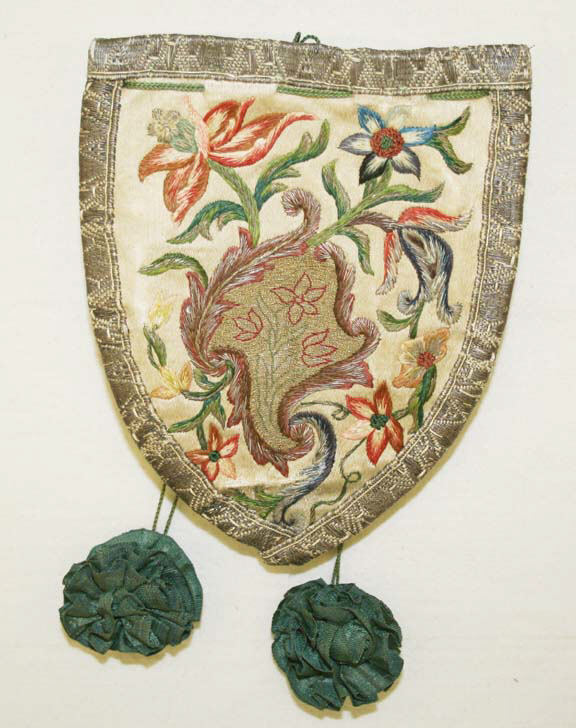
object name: purse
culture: french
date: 1701-1800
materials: linen, metal, silk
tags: flowers